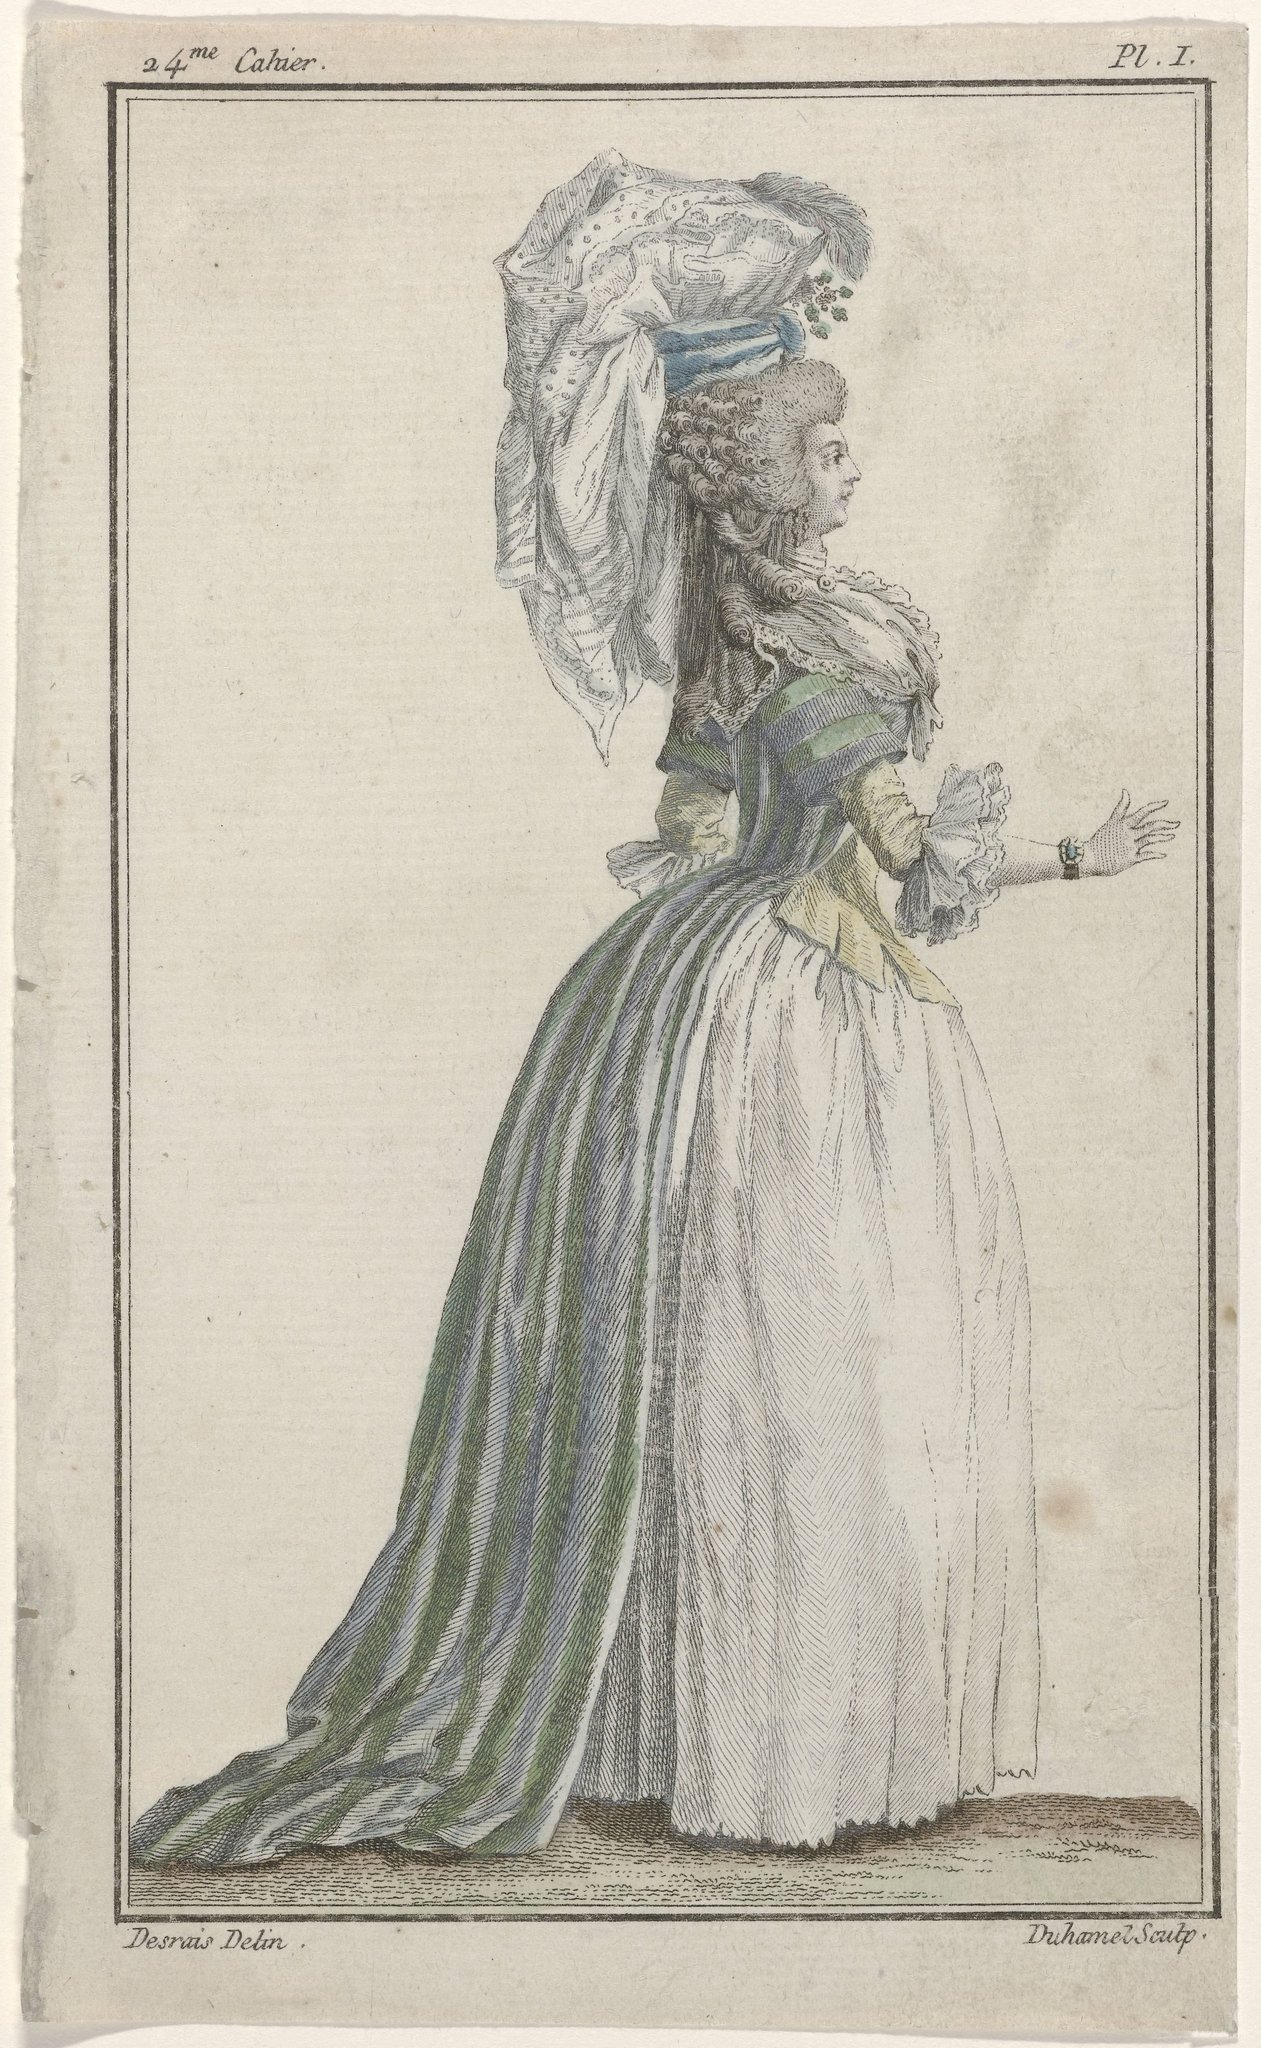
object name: fashion print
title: Cabinet des Modes ou les Modes Nouvelles, 1 novembre 1786, Pl. I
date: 1786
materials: paper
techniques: engraving, hand coloring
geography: paris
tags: ear-rings (+ women's clothes), styles of hairdress - aa - ~ women, head-gear: cap (+ women's clothes), fashion plates, dress, gown (+ women's clothes), piece of clothing covering the breast or décolleté (fichu) (+ women's clothes), bracelet, wristlet (+ women's clothes)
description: Volgens de begeleidende tekst is de vrouw gekleed in een 'robe à la Turque' van gestreept satijn met sleep. Hierbij draagt zij een fichu, lijfje met driekwart mouwen, geplooide kraag en dubbele manchetten en een witte rok met geschulpte zoom. Op het hoofd een "Bonnet à la Turque" van de "demoiselle Roussaud, au coin de la rue du Théatre Francais". Accessoires: oorbellen, armband. De prent maakt deel uit van het 24e Cahier uit de serie Cabinet des Modes ou les Modes Nouvelles. De serie bestaat uit 72 modeprenten, uitgegeven door Buisson, Parijs, 15 november 1785 - 1 november 1786.